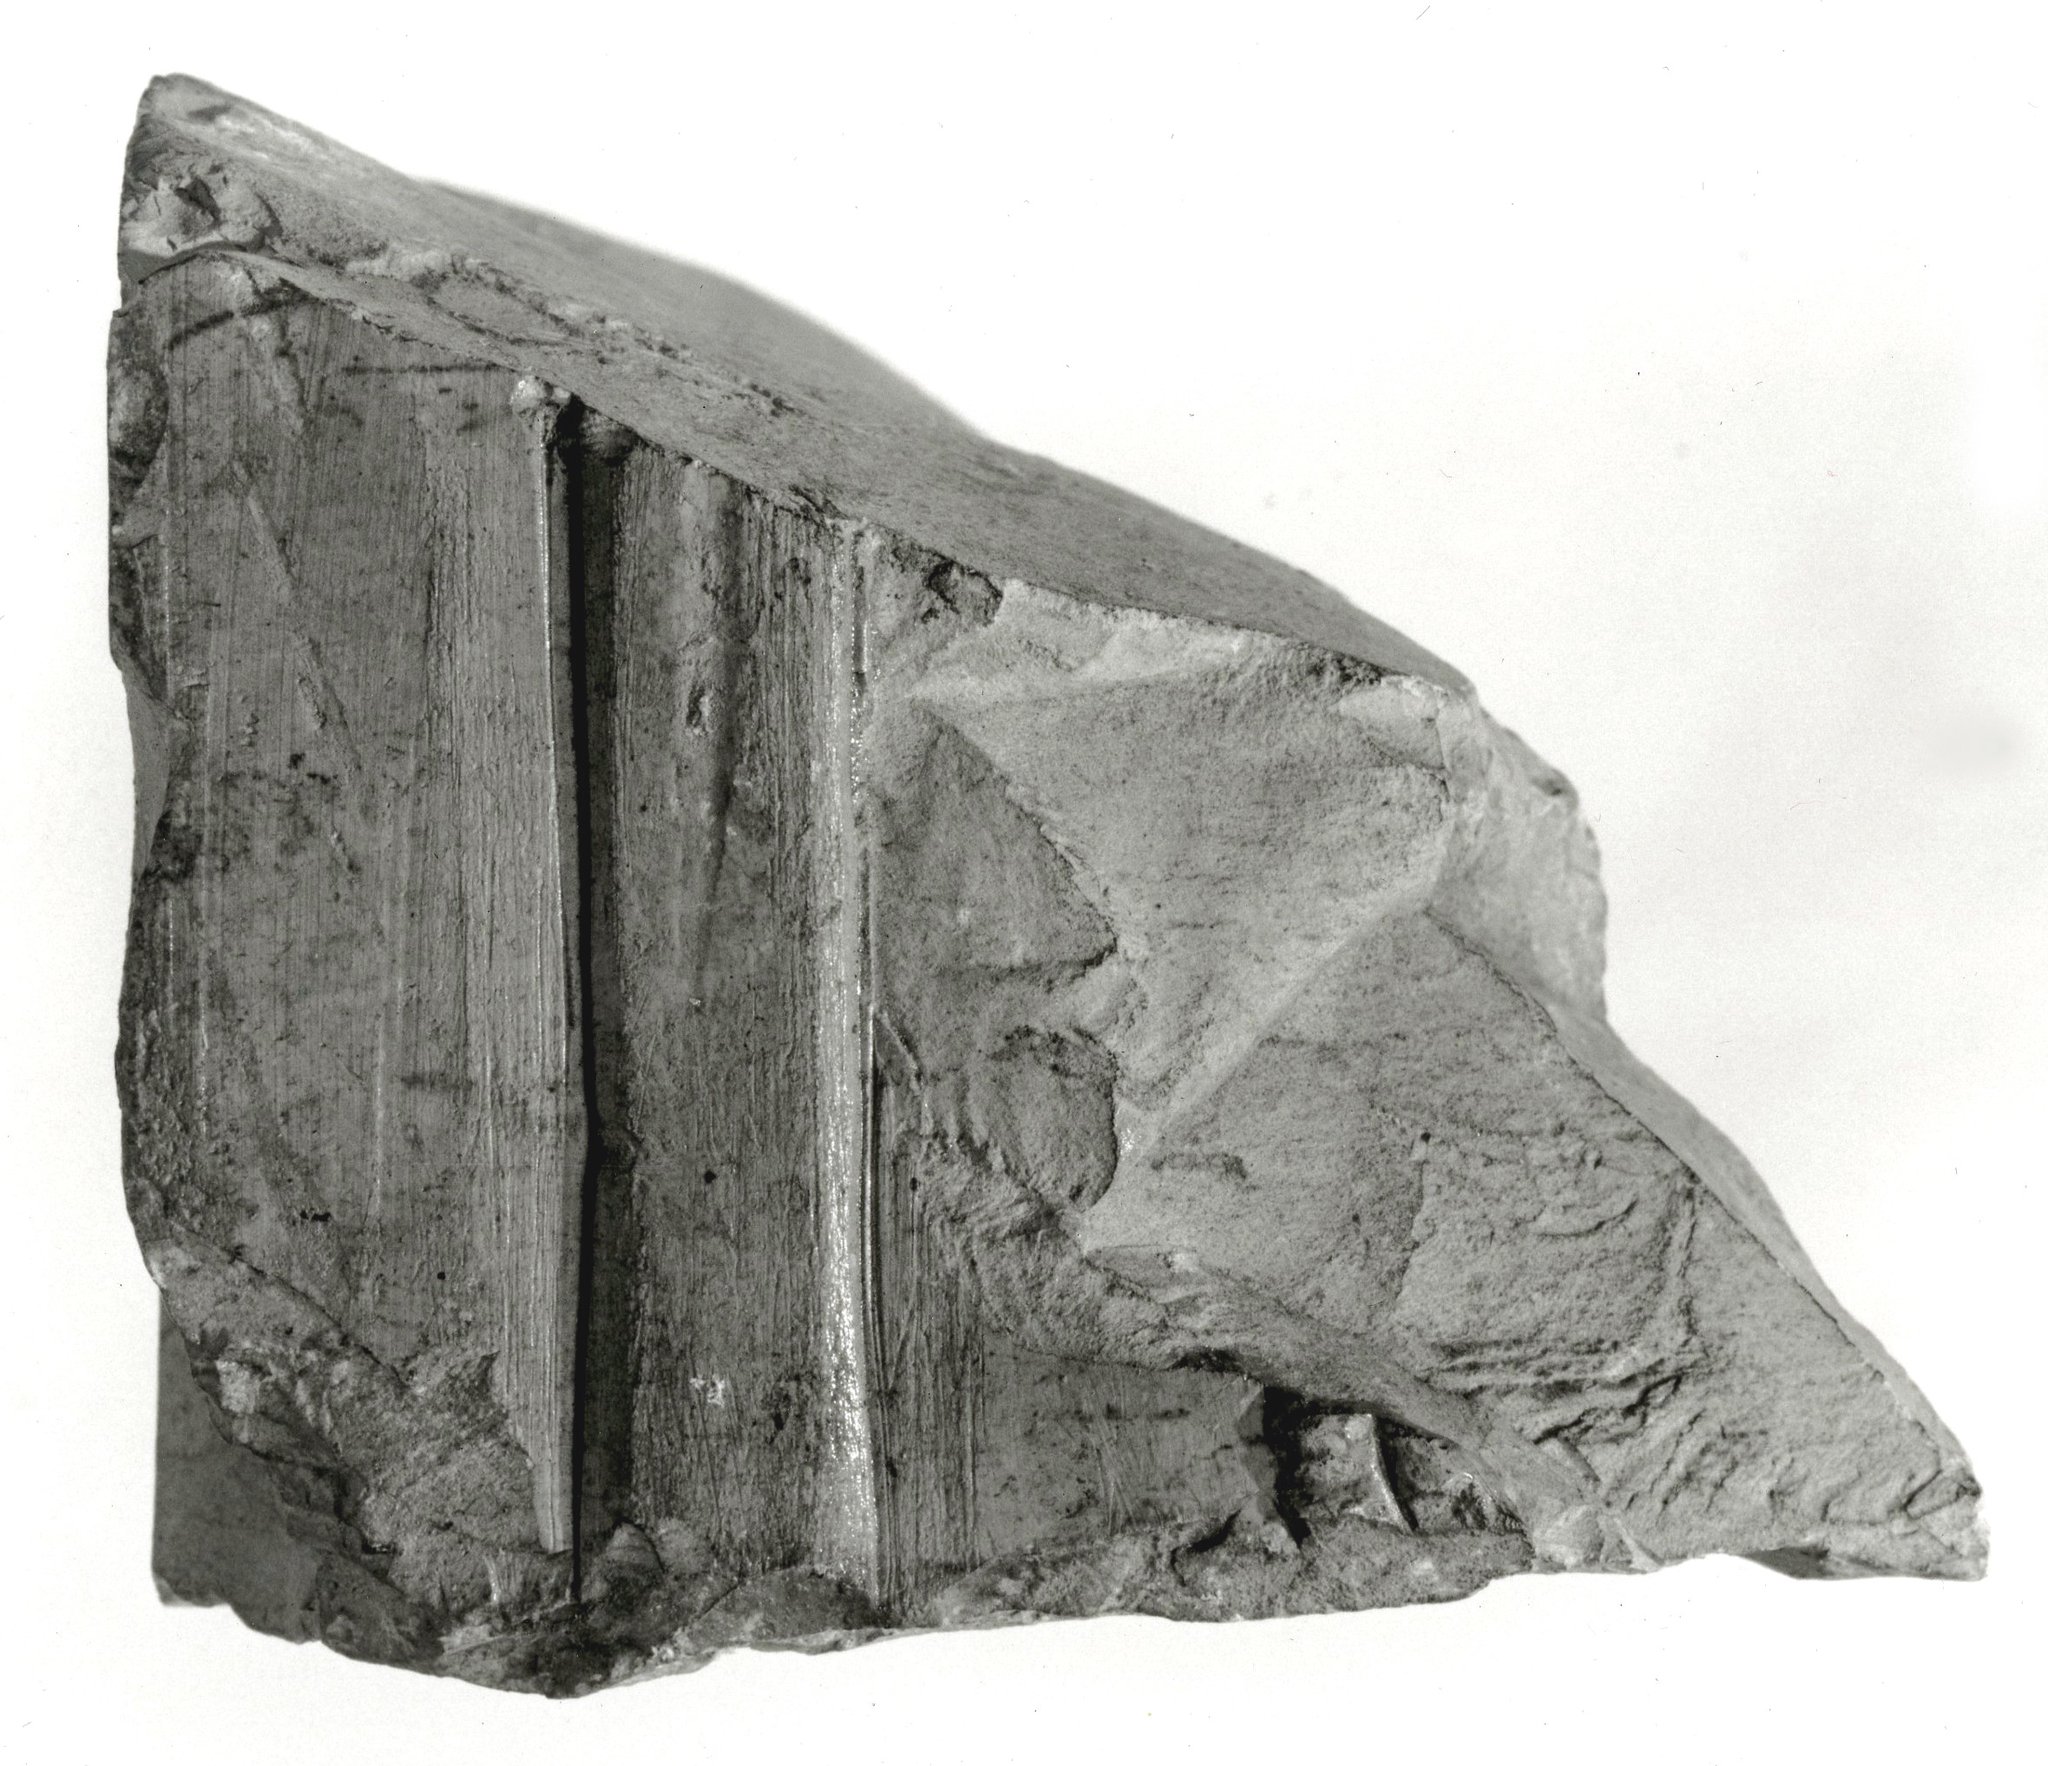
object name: relief, tomb of nespekashuty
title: Raised relief fragment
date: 664-610 BCE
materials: limestone, varnish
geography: egypt